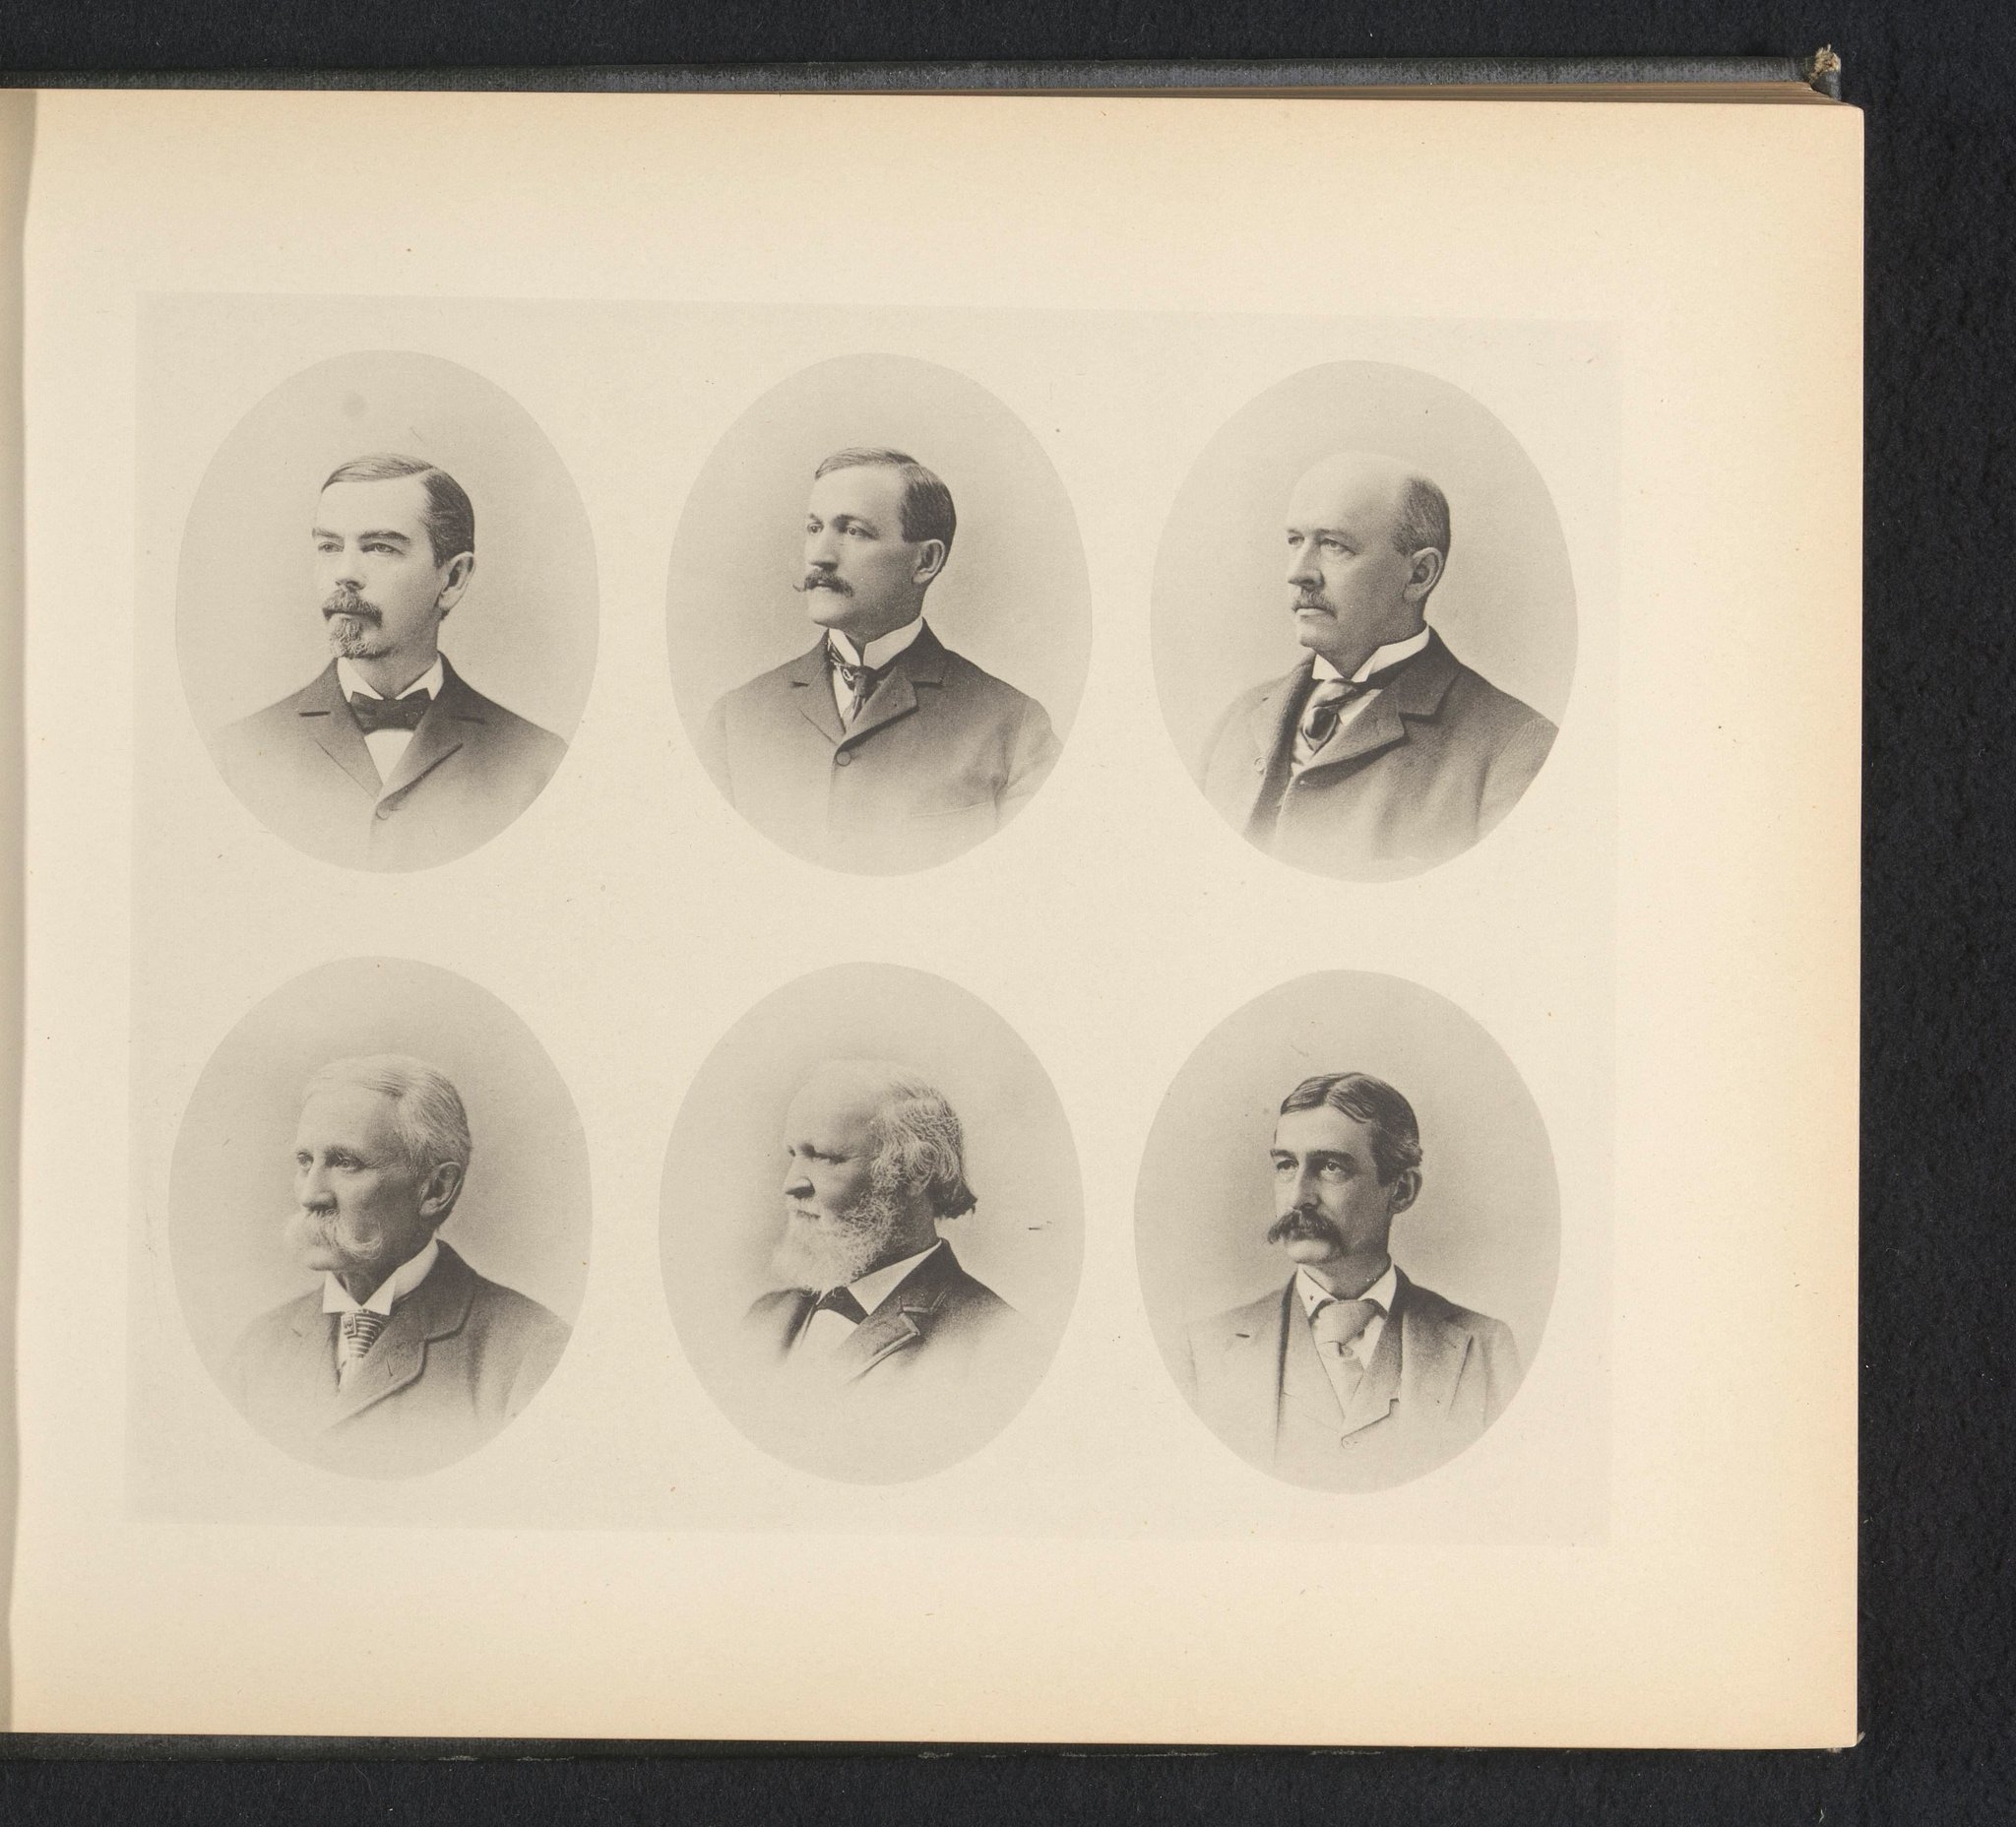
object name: page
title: Zes portretten van docenten aan Yale University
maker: Anonymous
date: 1895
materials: paper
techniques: photograph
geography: new york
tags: professor